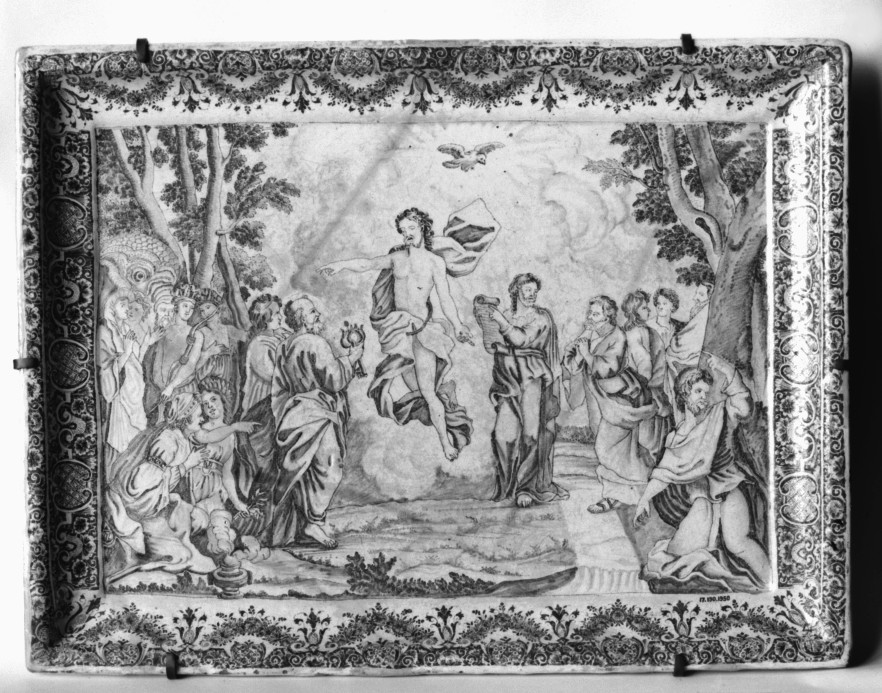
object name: plateau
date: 1725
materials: faience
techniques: glazing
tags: birds,men,trees